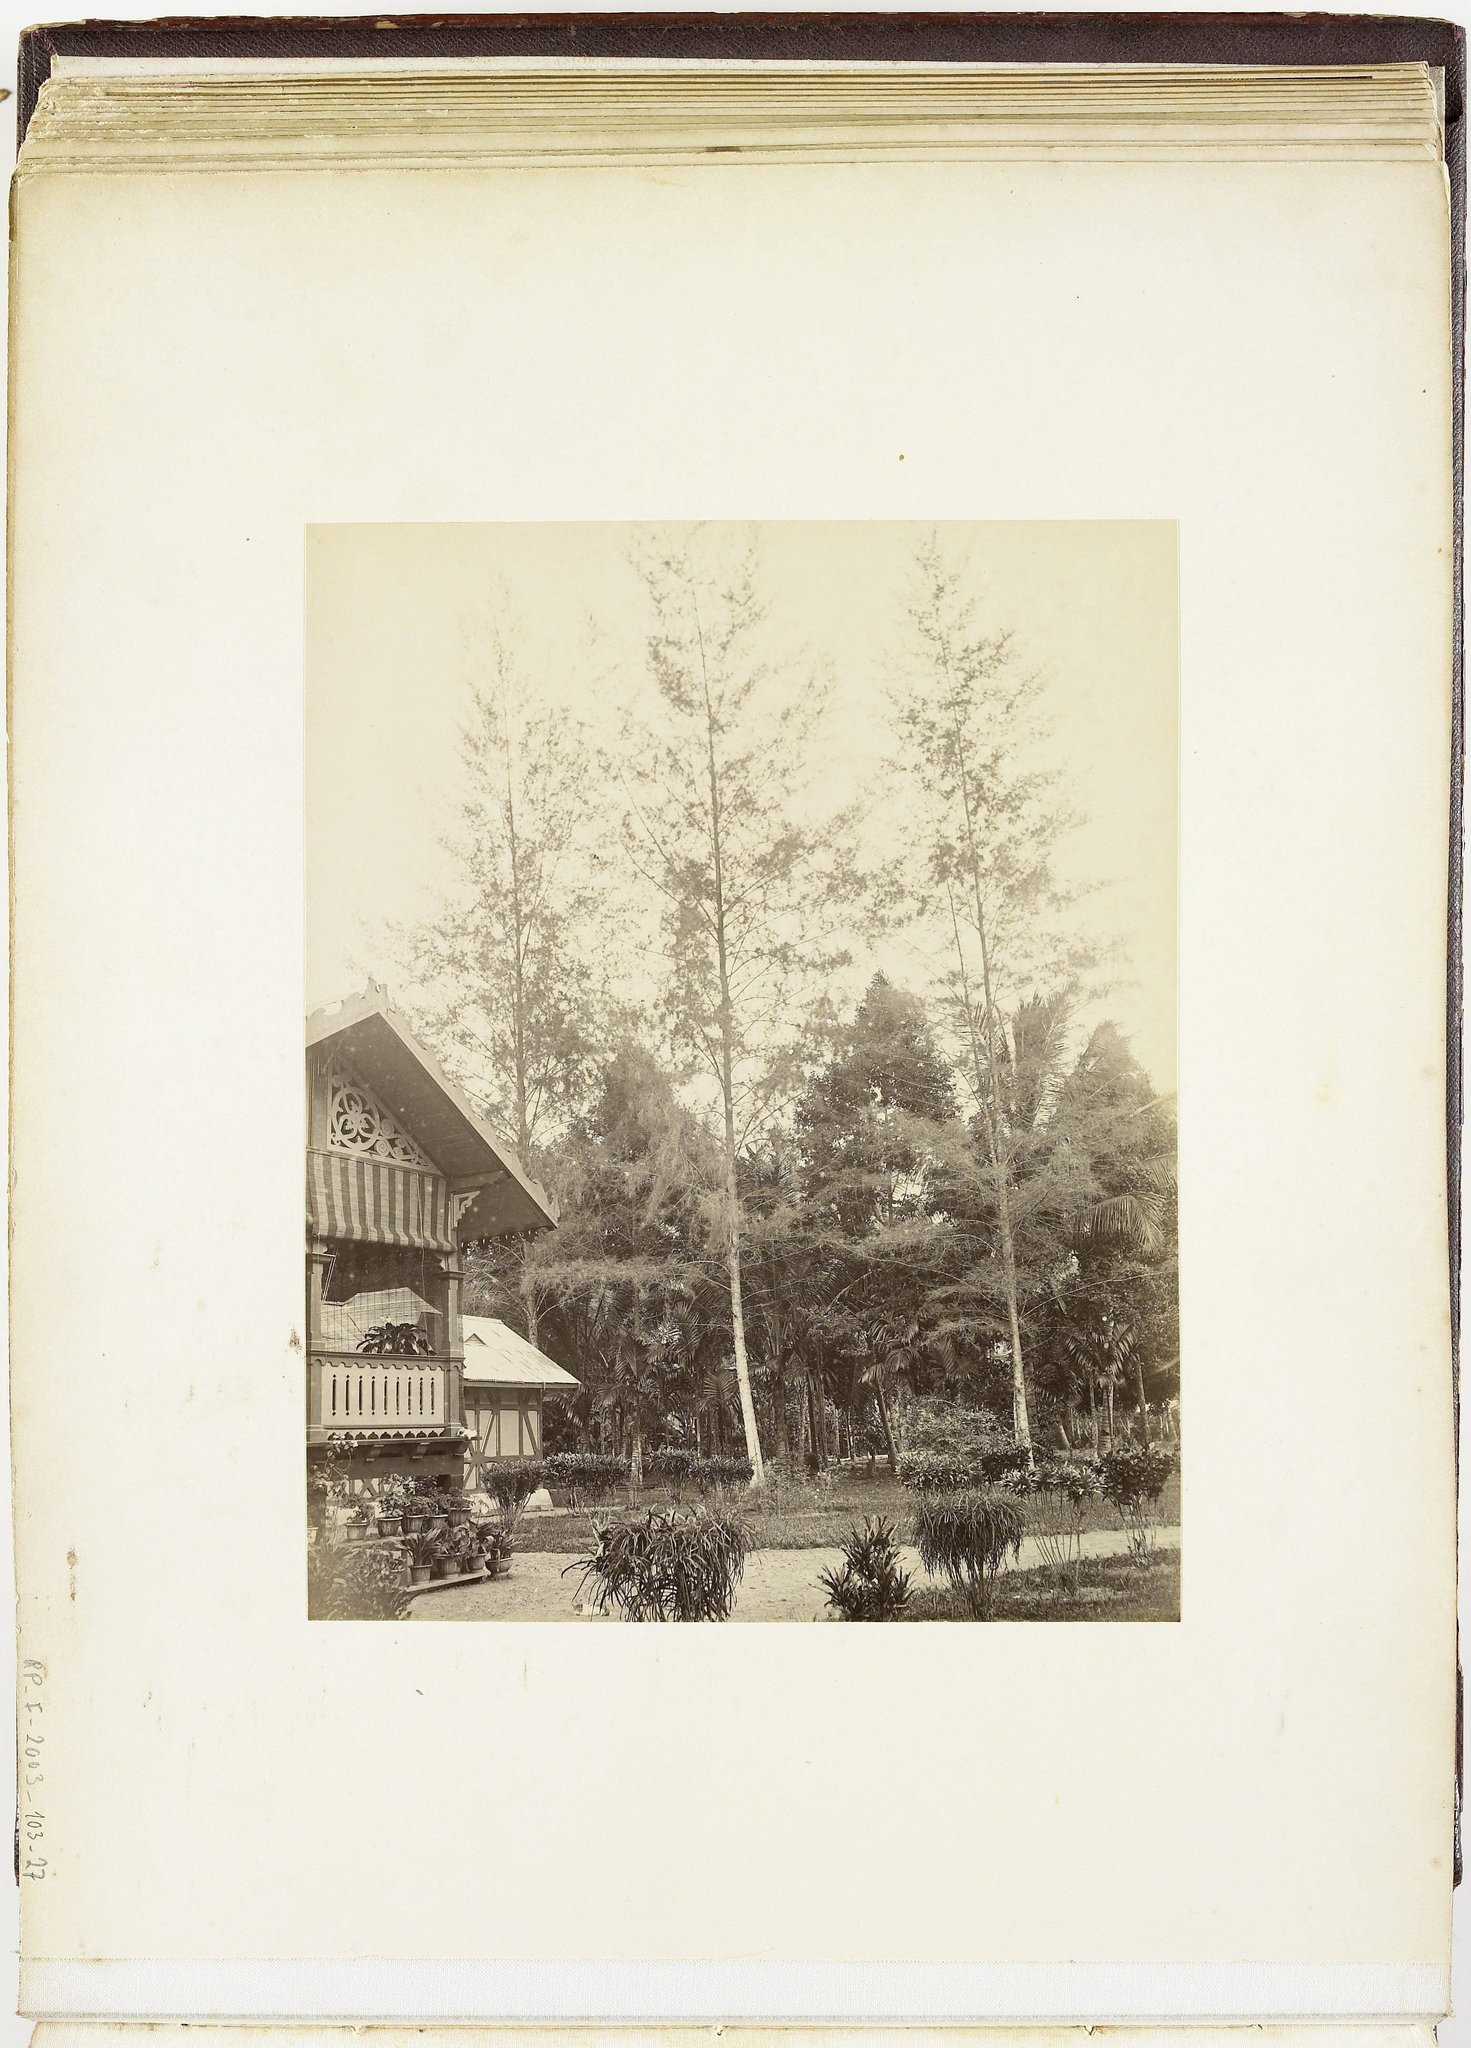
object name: photograph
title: Gezicht op huis met tuin en hoge bomen, Langkat Sumatra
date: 1890-1900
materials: cardboard, paper, photographic support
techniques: albumen print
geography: bindjai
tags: sumatra